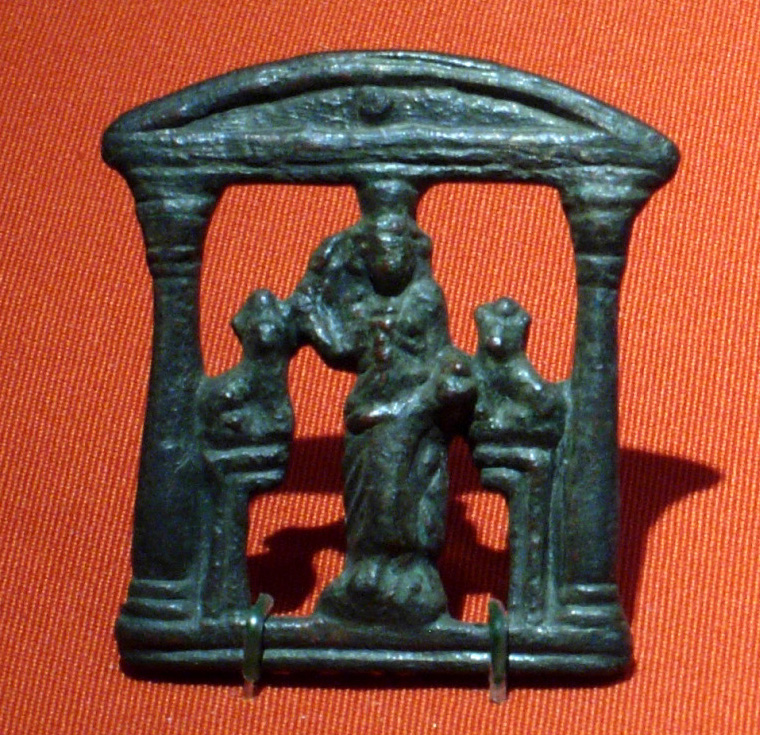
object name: plaque, openwork shrine kiosk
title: Plaque representing an Egyptian open shrine (kiosk)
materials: bronze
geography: egypt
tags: human figures